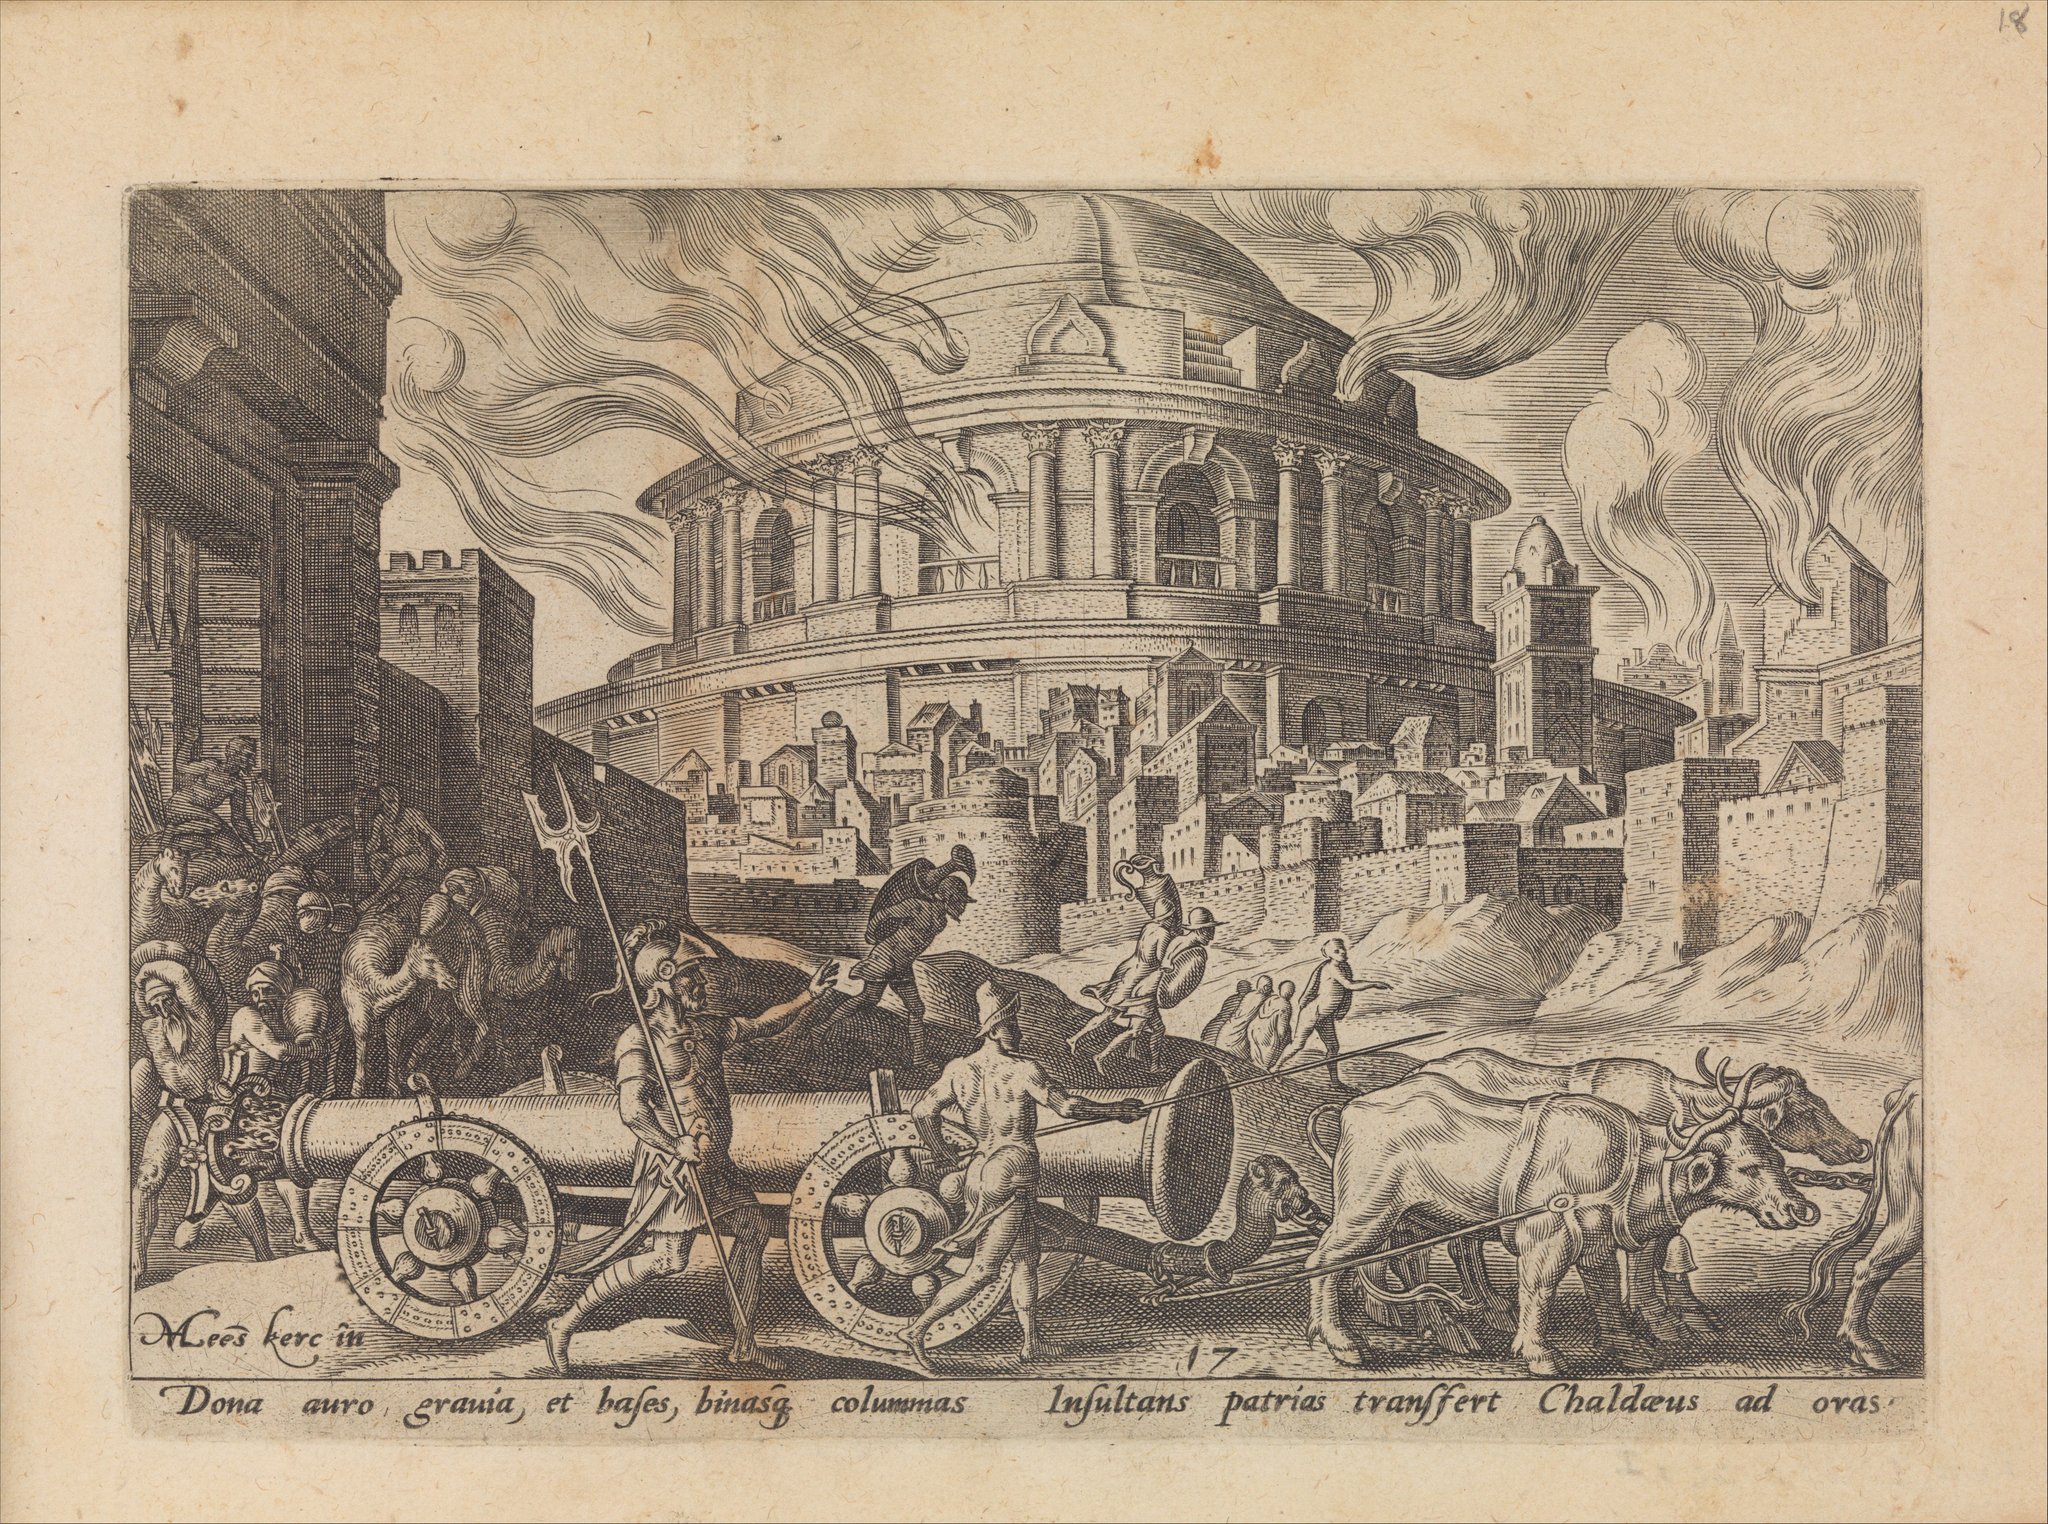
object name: print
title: The Chaldeans Carrying Away the Pillars of the Temple of Jerusalem, from The Disasters of the Jewish People, plate 17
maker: philips galle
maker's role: artist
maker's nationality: netherlandish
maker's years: 1537-1612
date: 1569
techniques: engraving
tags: animals,buildings,temples,men,fire